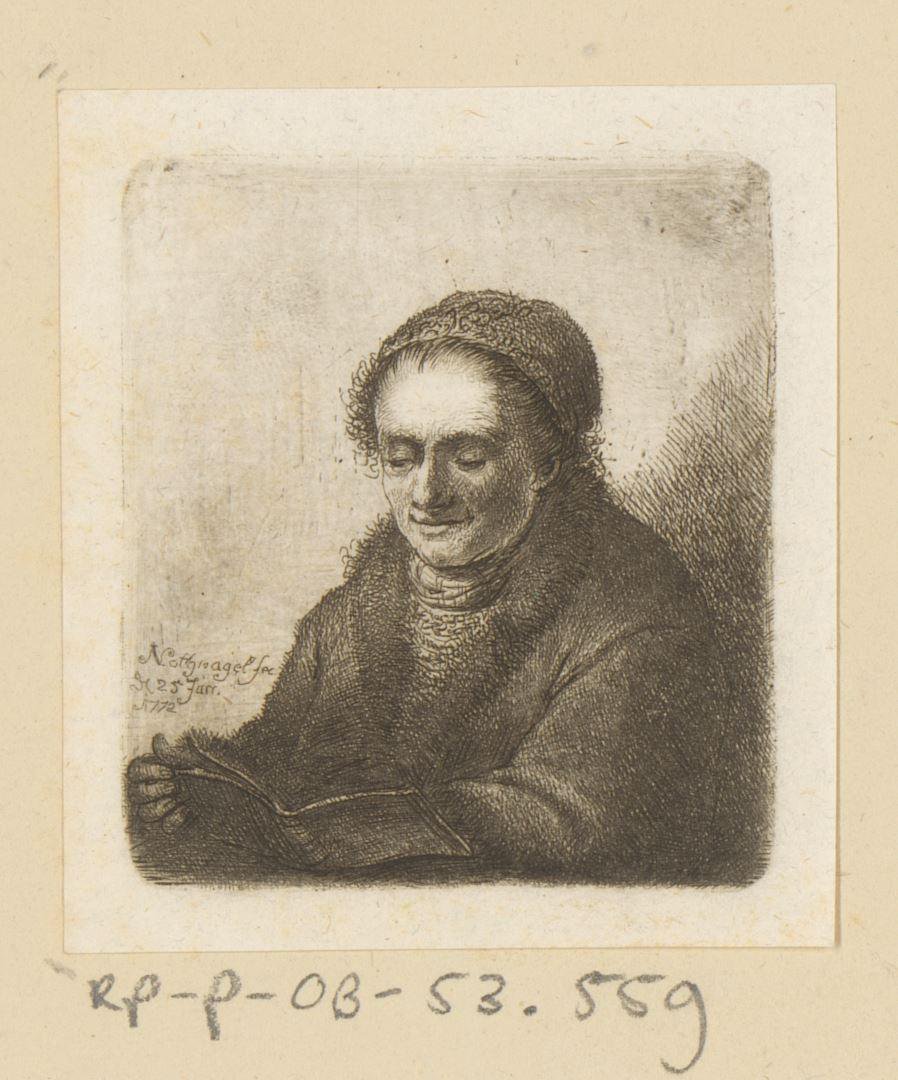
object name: print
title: Lezende vrouw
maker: johann andreas benjamin nothnagel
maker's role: print maker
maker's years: 1729-1804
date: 1772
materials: paper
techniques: etching, intaglio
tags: adult woman, reading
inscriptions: collector's mark: Lugt 240